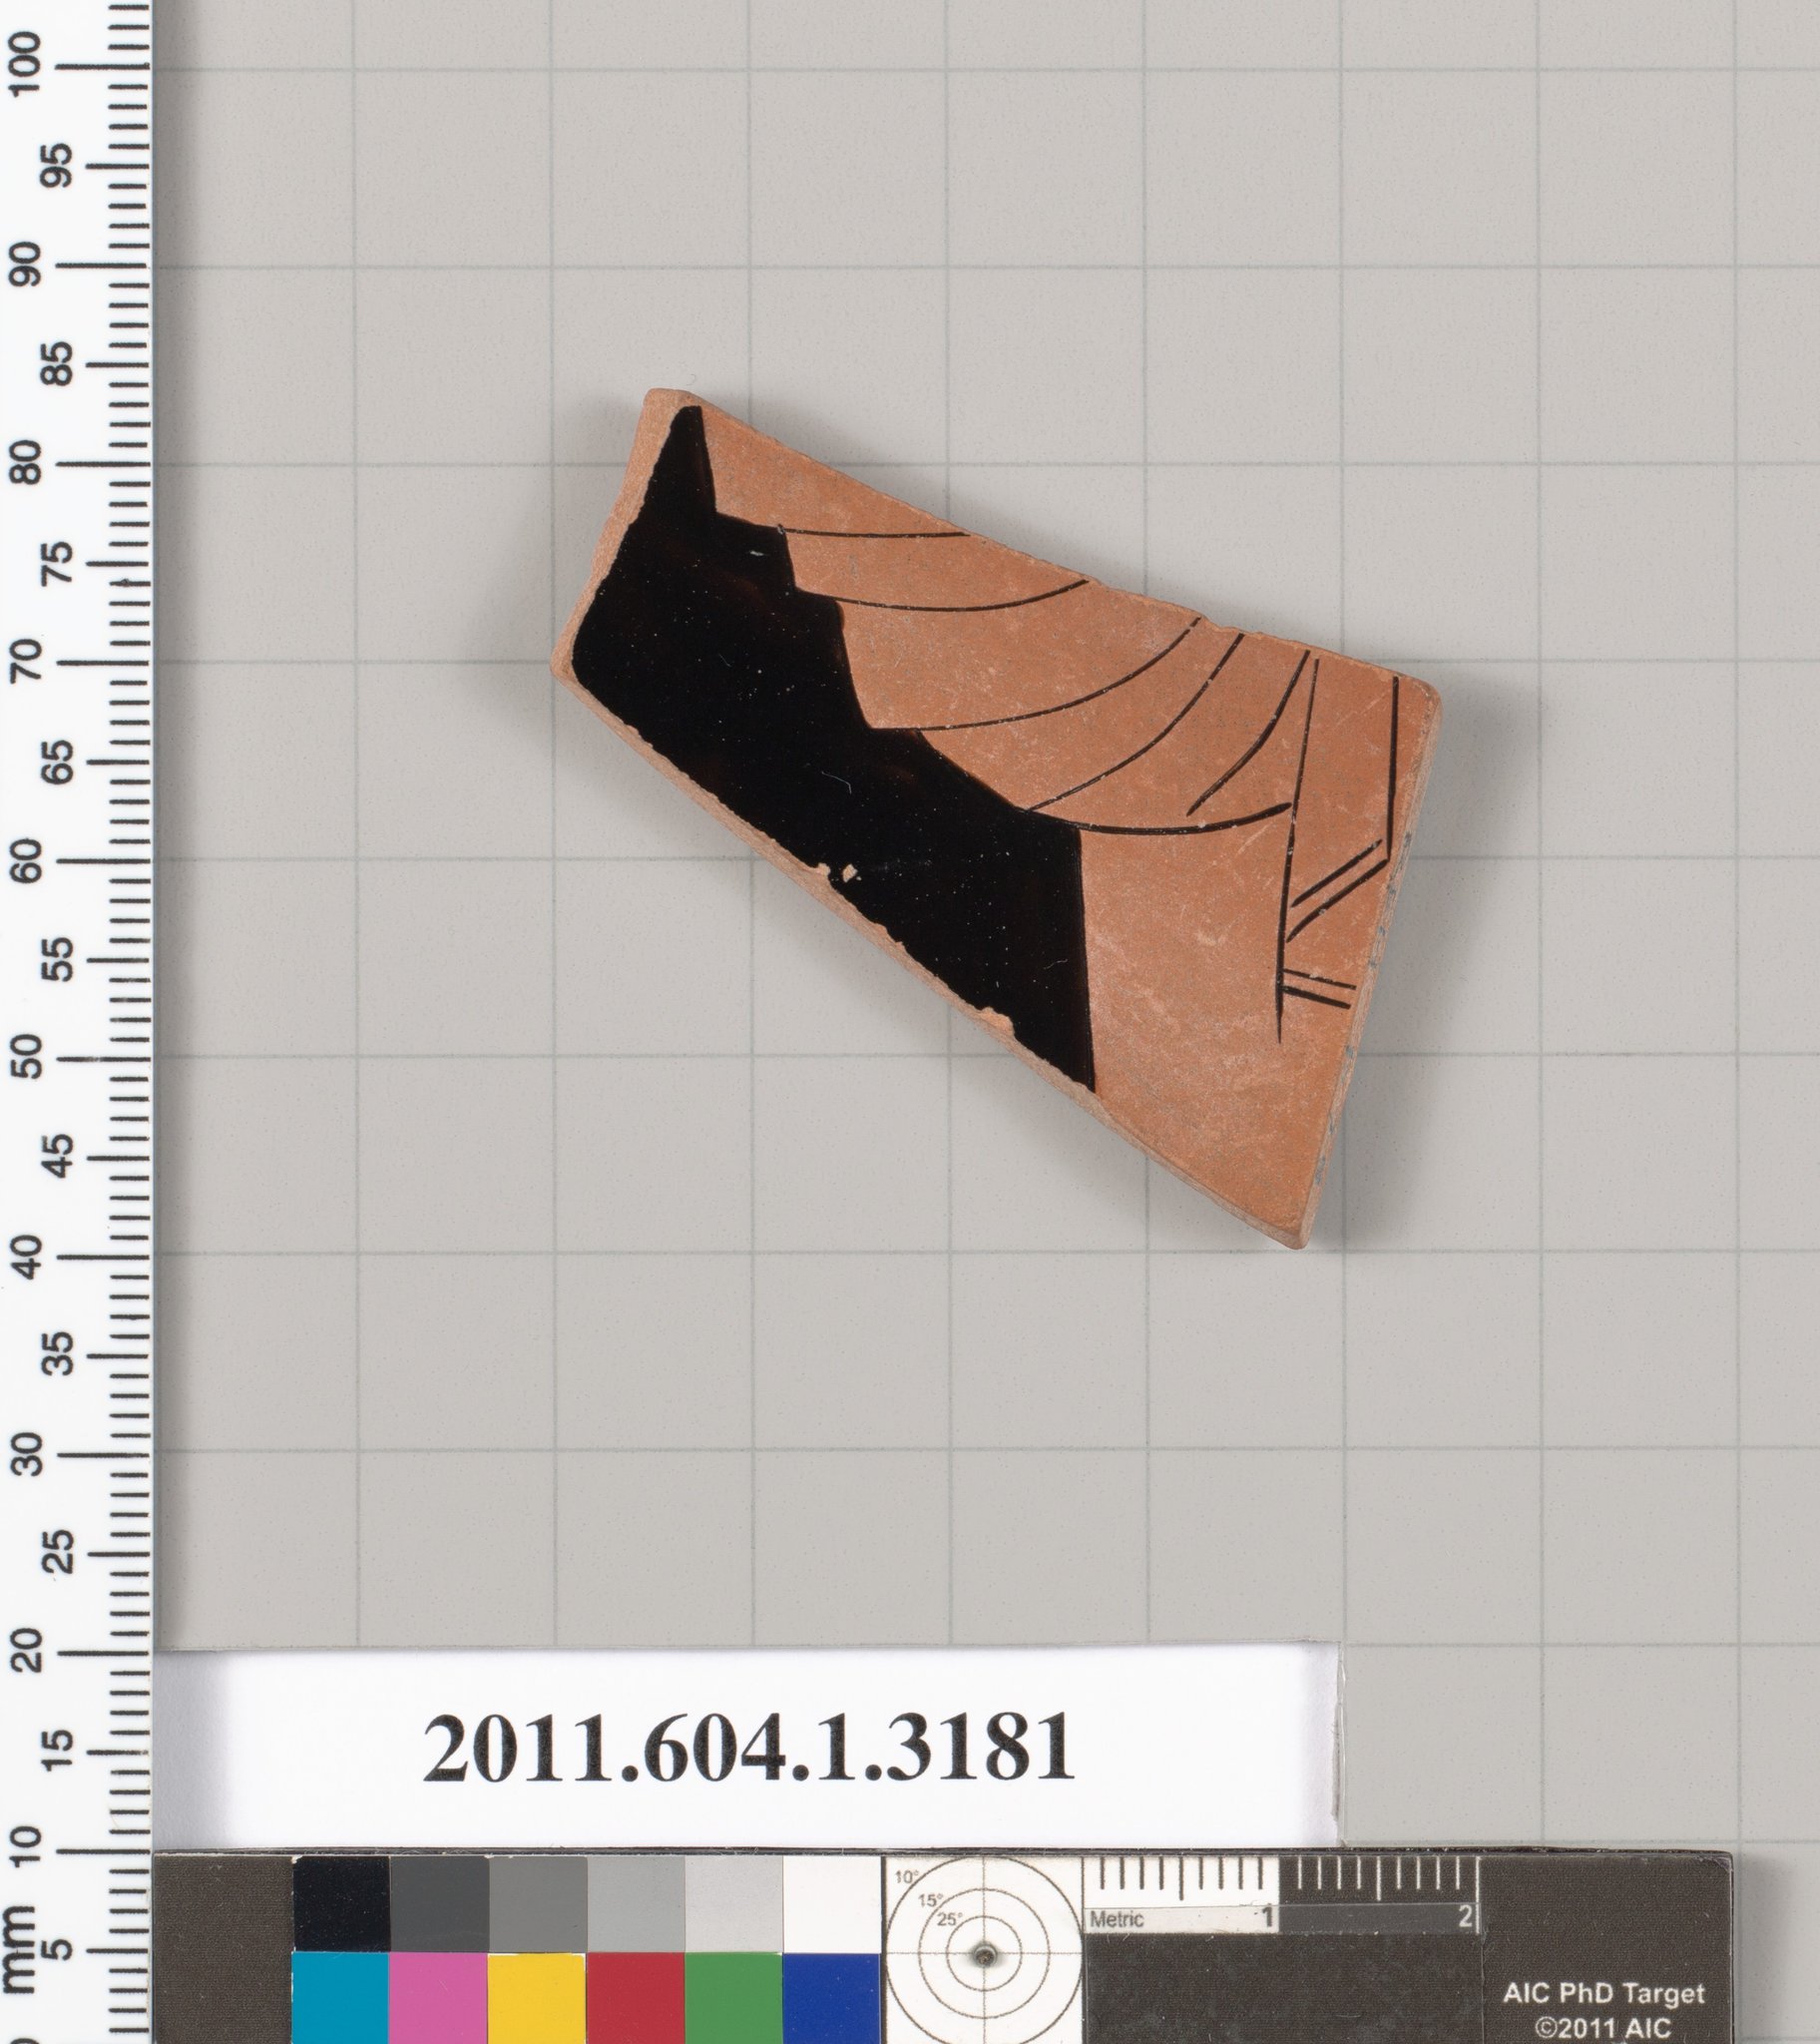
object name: kylix fragment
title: Terracotta fragment of a kylix (drinking cup)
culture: greek, attic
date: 500-476 BCE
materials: terracotta